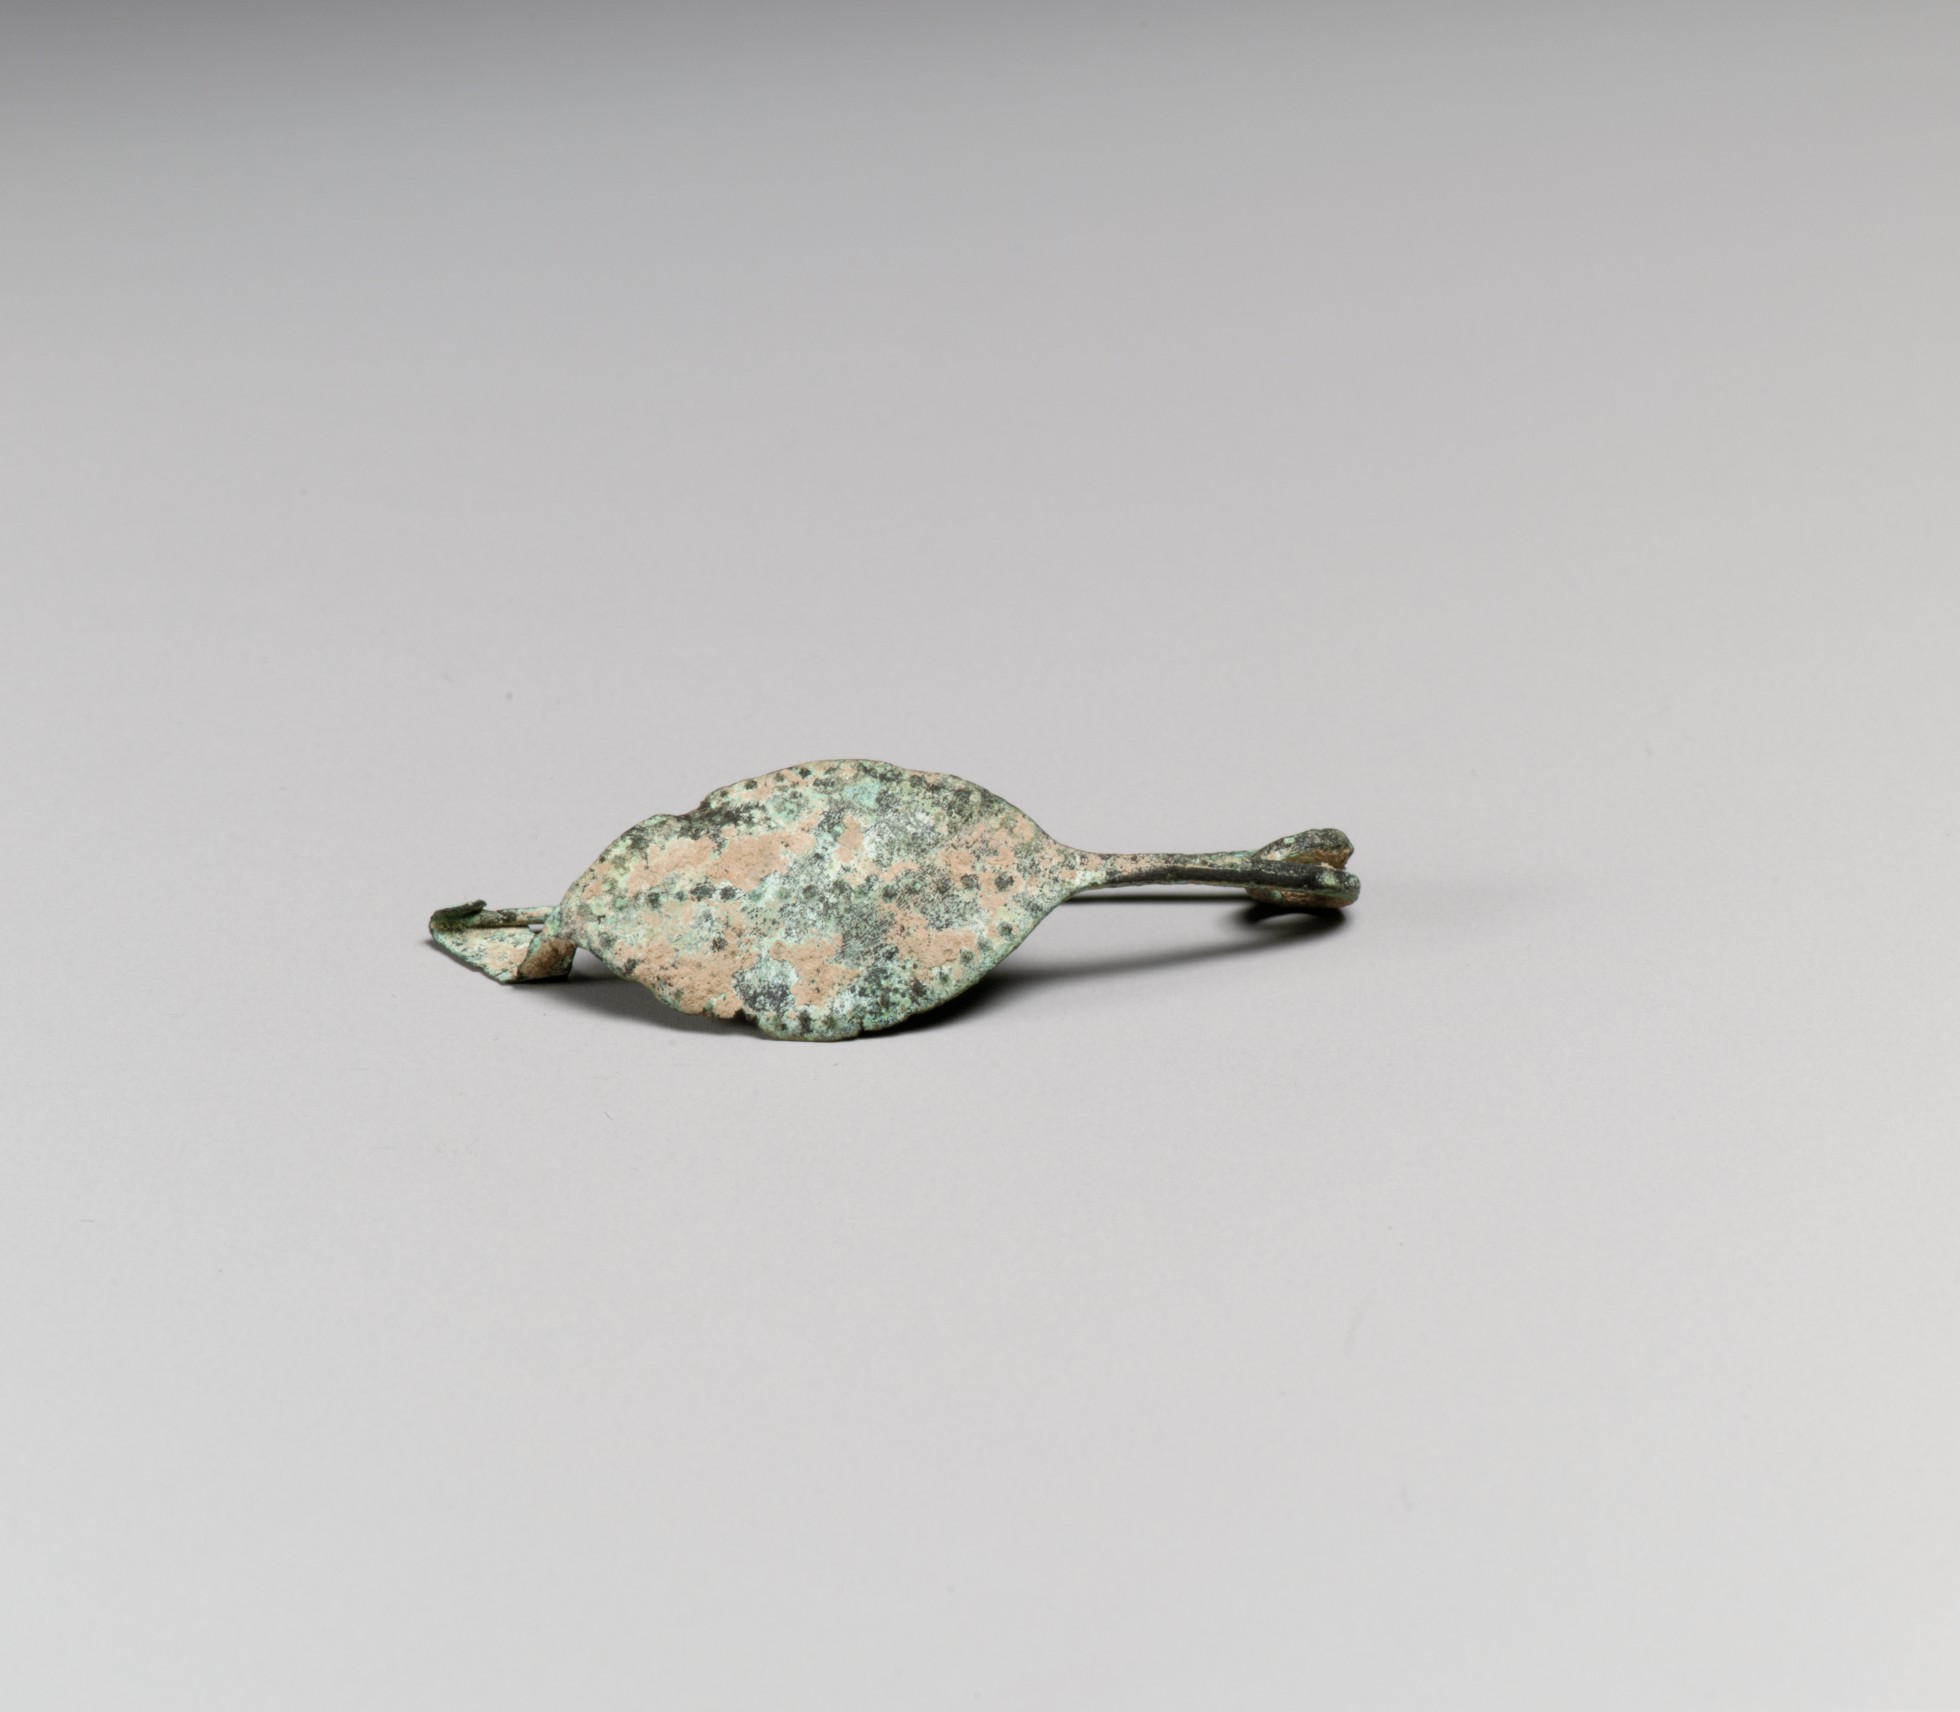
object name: fibula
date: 7000 BCE-330 CE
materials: bronze